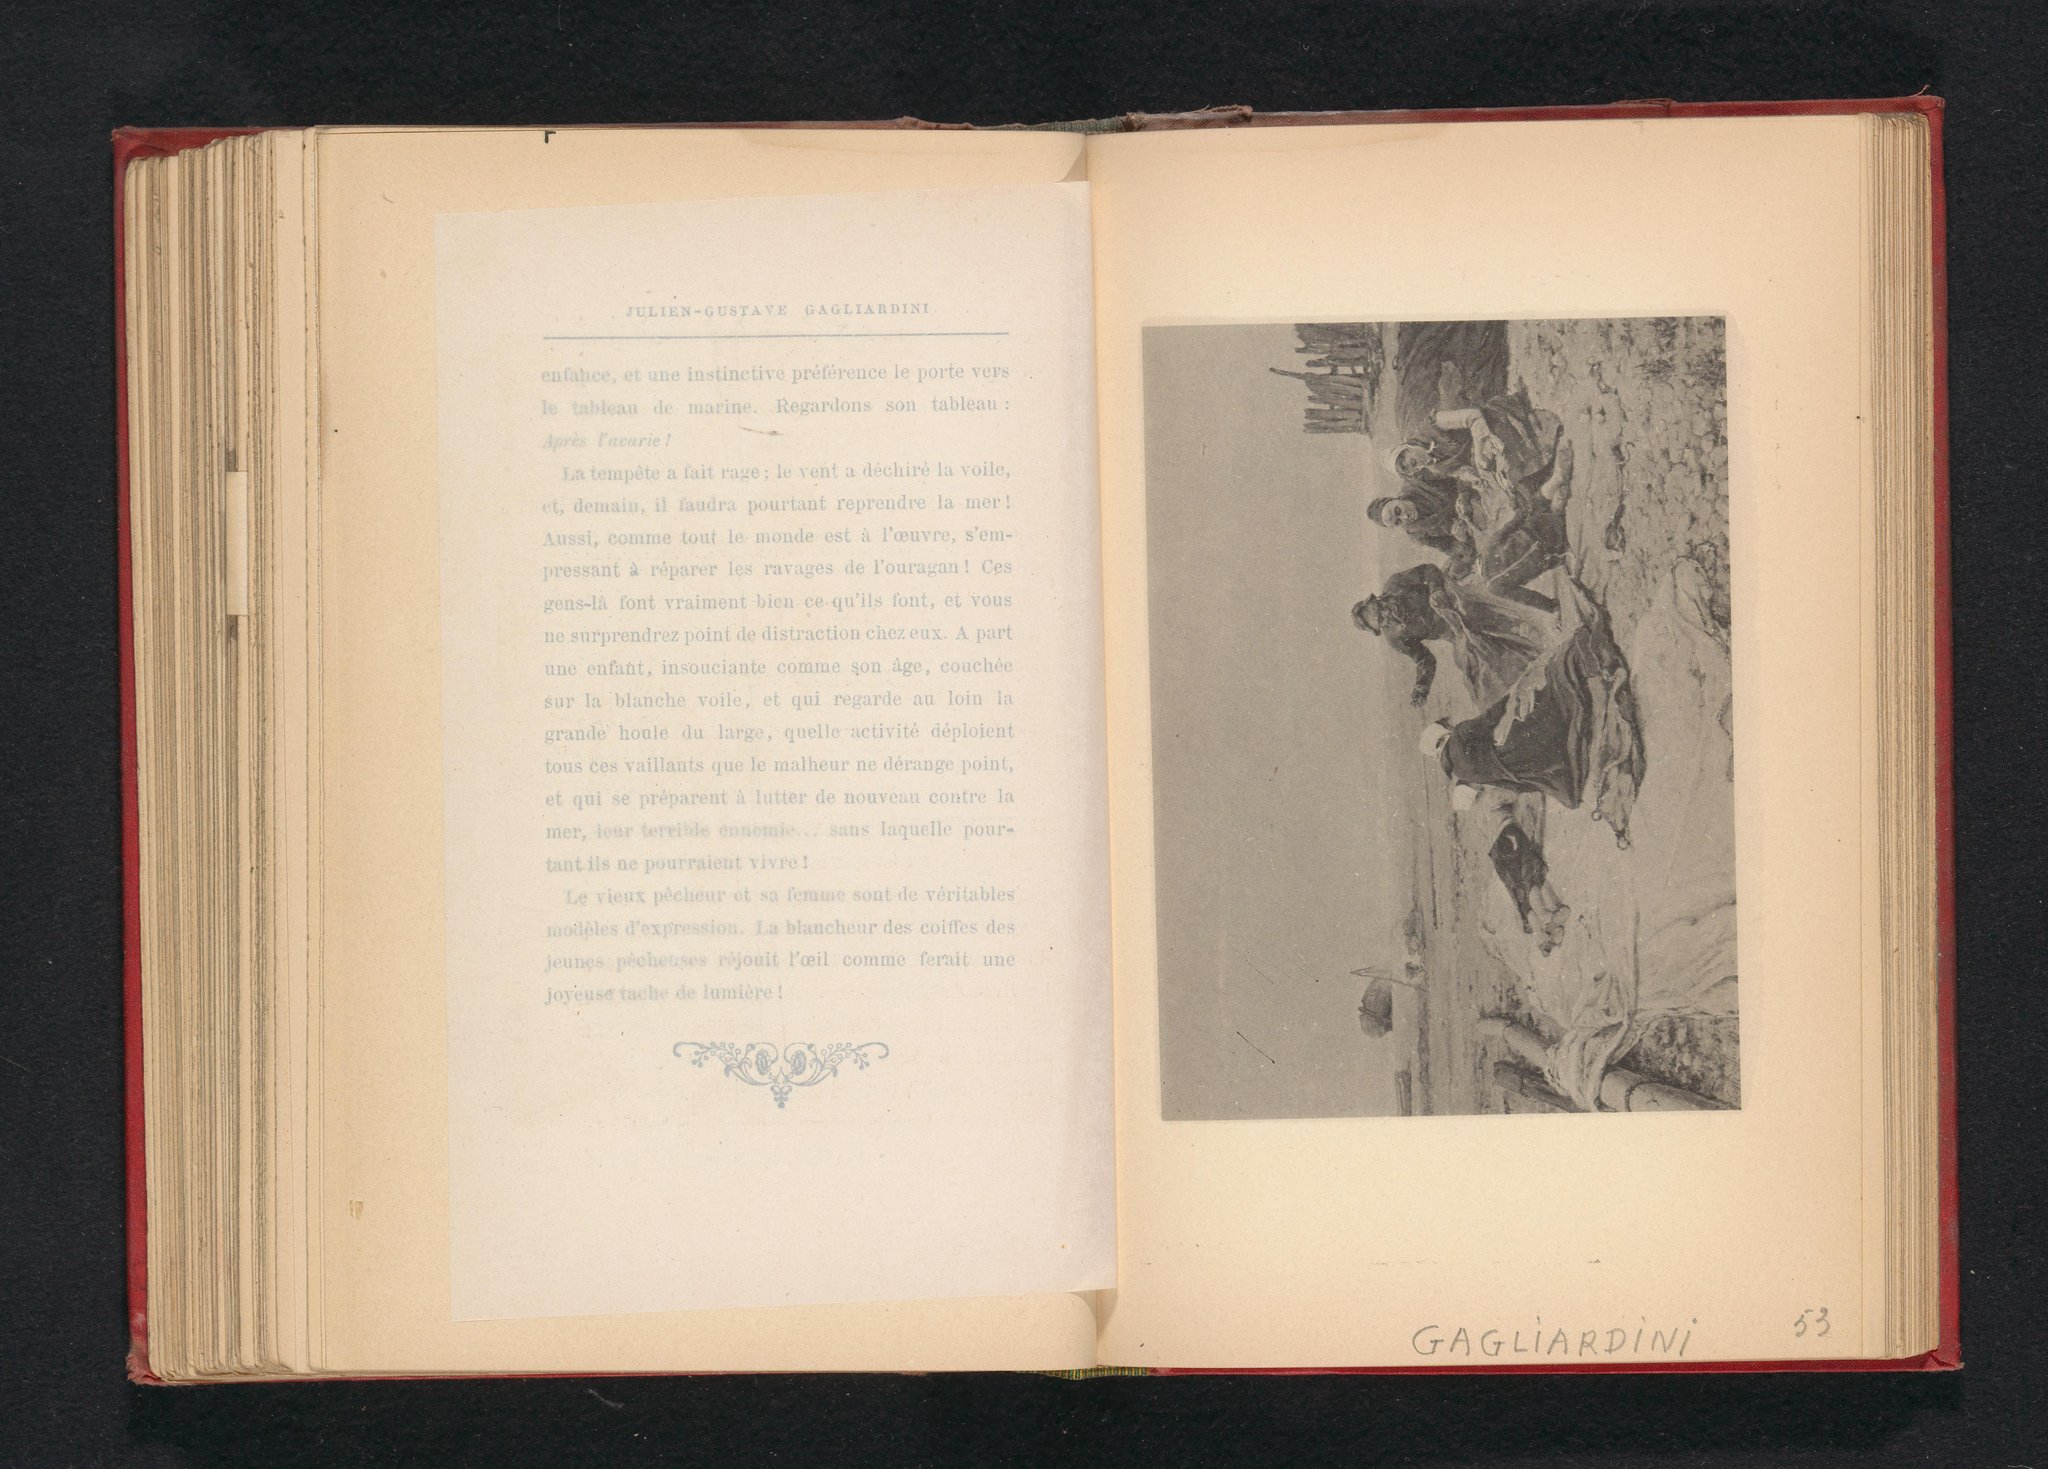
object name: page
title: Fotoreproductie van een schilderij, voorstellende een gezin naait een zeil op een strand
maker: julien gustave gagliardini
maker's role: painter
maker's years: 1846-1927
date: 1872-1882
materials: paper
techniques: photograph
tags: sail, care and laundering of clothes; home sewing